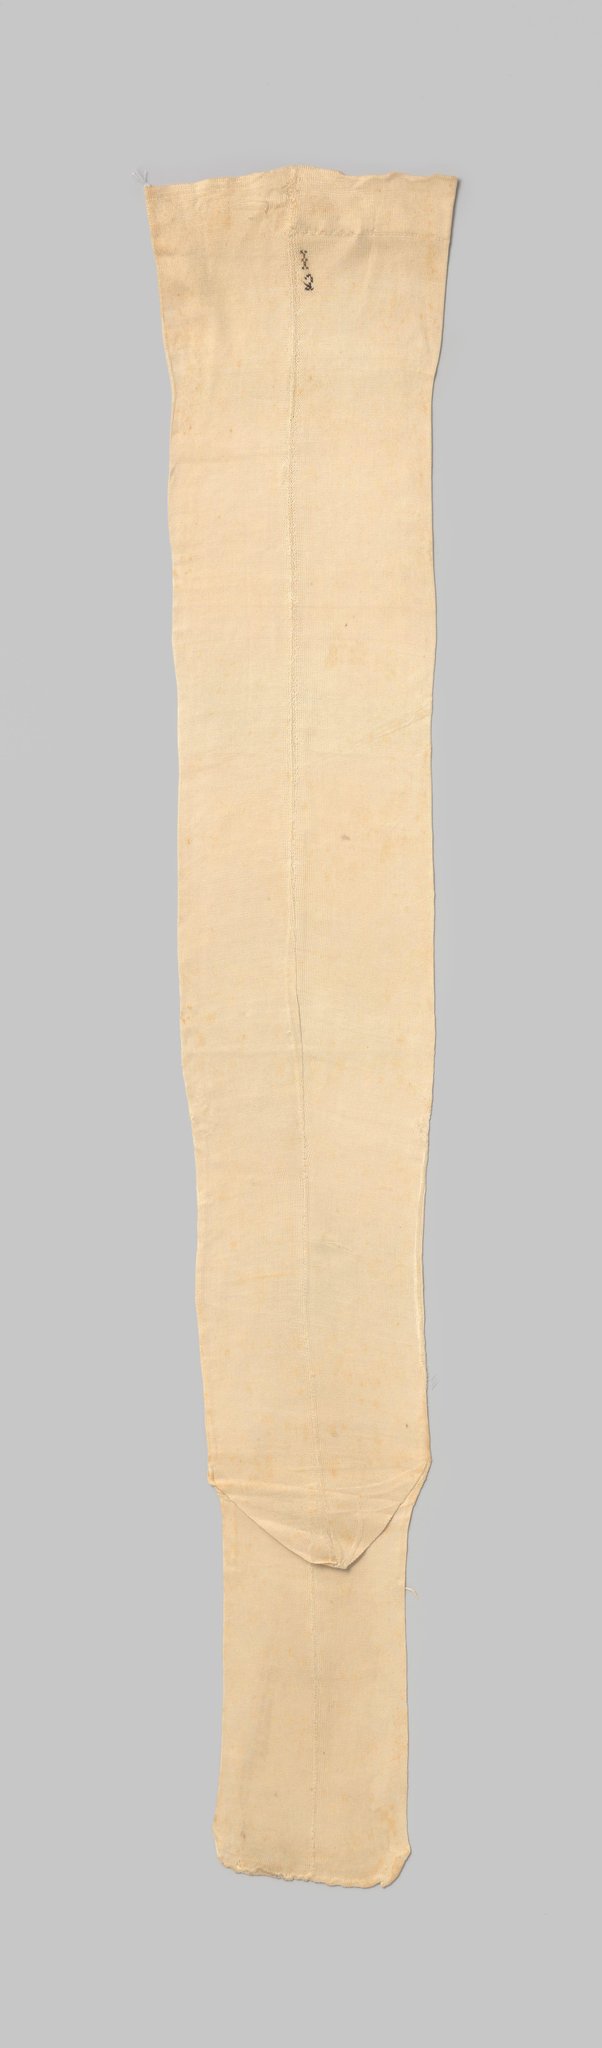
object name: stocking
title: Kous van witte zijde in tricotsteek, onderaan aan één zijde versierd met een geborduurde sierlijn, eindigend in een bloem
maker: Anonymous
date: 1815-1830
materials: silk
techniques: embroidered, knitting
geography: netherlands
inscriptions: mark: ‘''XX 2'’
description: Gebreide kous van witte zijde in tricotsteek, onderaan aan één zijde versierd met een geborduurde sierlijn, eindigend in een bloem; in zwarte kruissteek gemerkt: XX2. Mogelijk hofkleding.